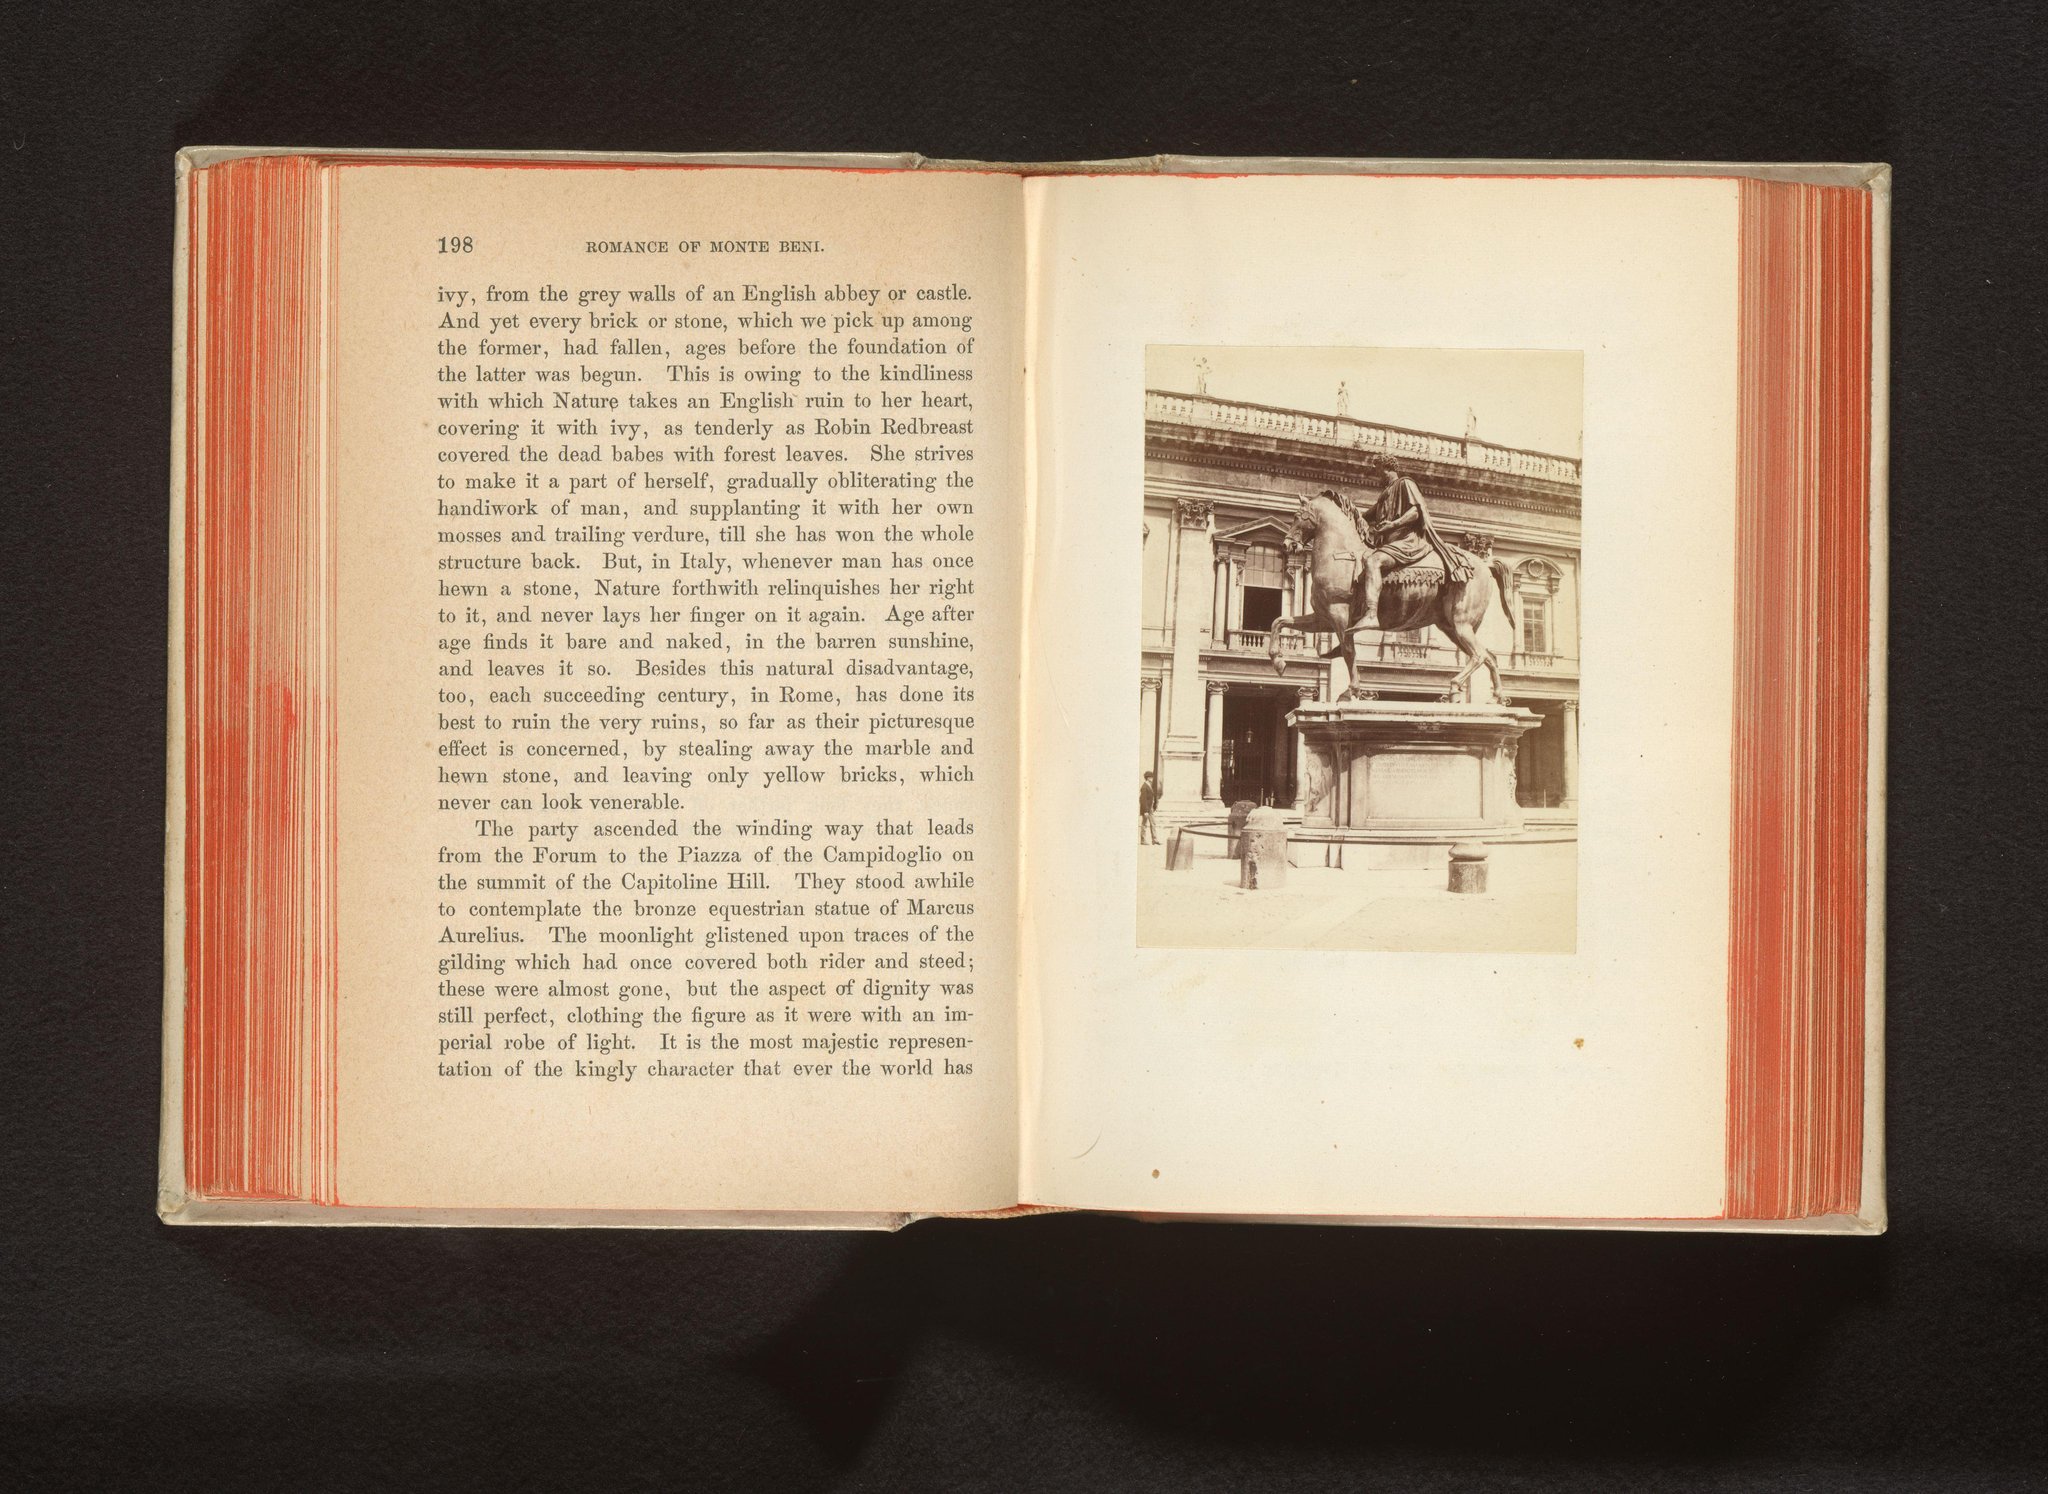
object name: photograph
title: Ruiterstandbeeld van Marcus Aurelius op het Piazza del Campidoglio in Rome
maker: Anonymous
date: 1850-1860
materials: photographic support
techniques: albumen print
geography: piazza del campidoglio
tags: rome, equestrian statue